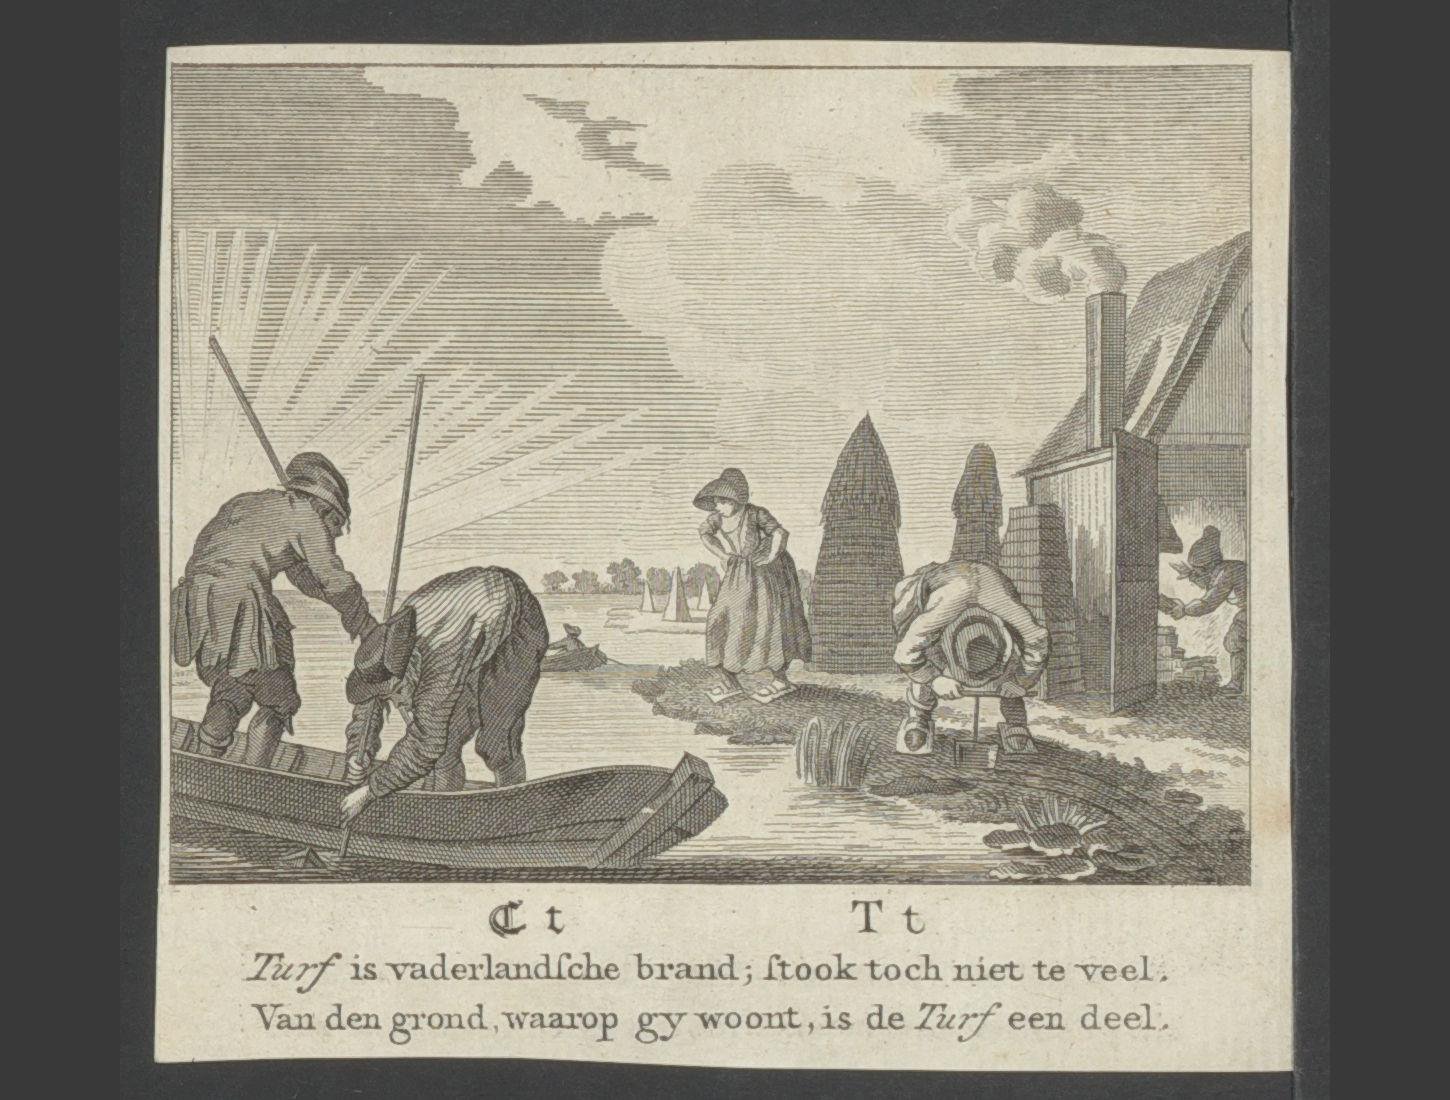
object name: print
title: Turf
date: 1781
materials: paper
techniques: engraving, etching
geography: amsterdam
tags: peat (soil type), letters, alphabet, script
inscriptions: collector's mark: Lugt 1641, stamp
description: Onder de voorstelling de letter T in twee verschillende lettertypes. Onderaan een tweeregelig vers over turf. Onderwerpsrubrieken binnen de Atlas Zeden en Gewoonten: Onderwijs en Wetenschappen, Opvoeding en Onderwijs, Haneboeken en schoolprenten.